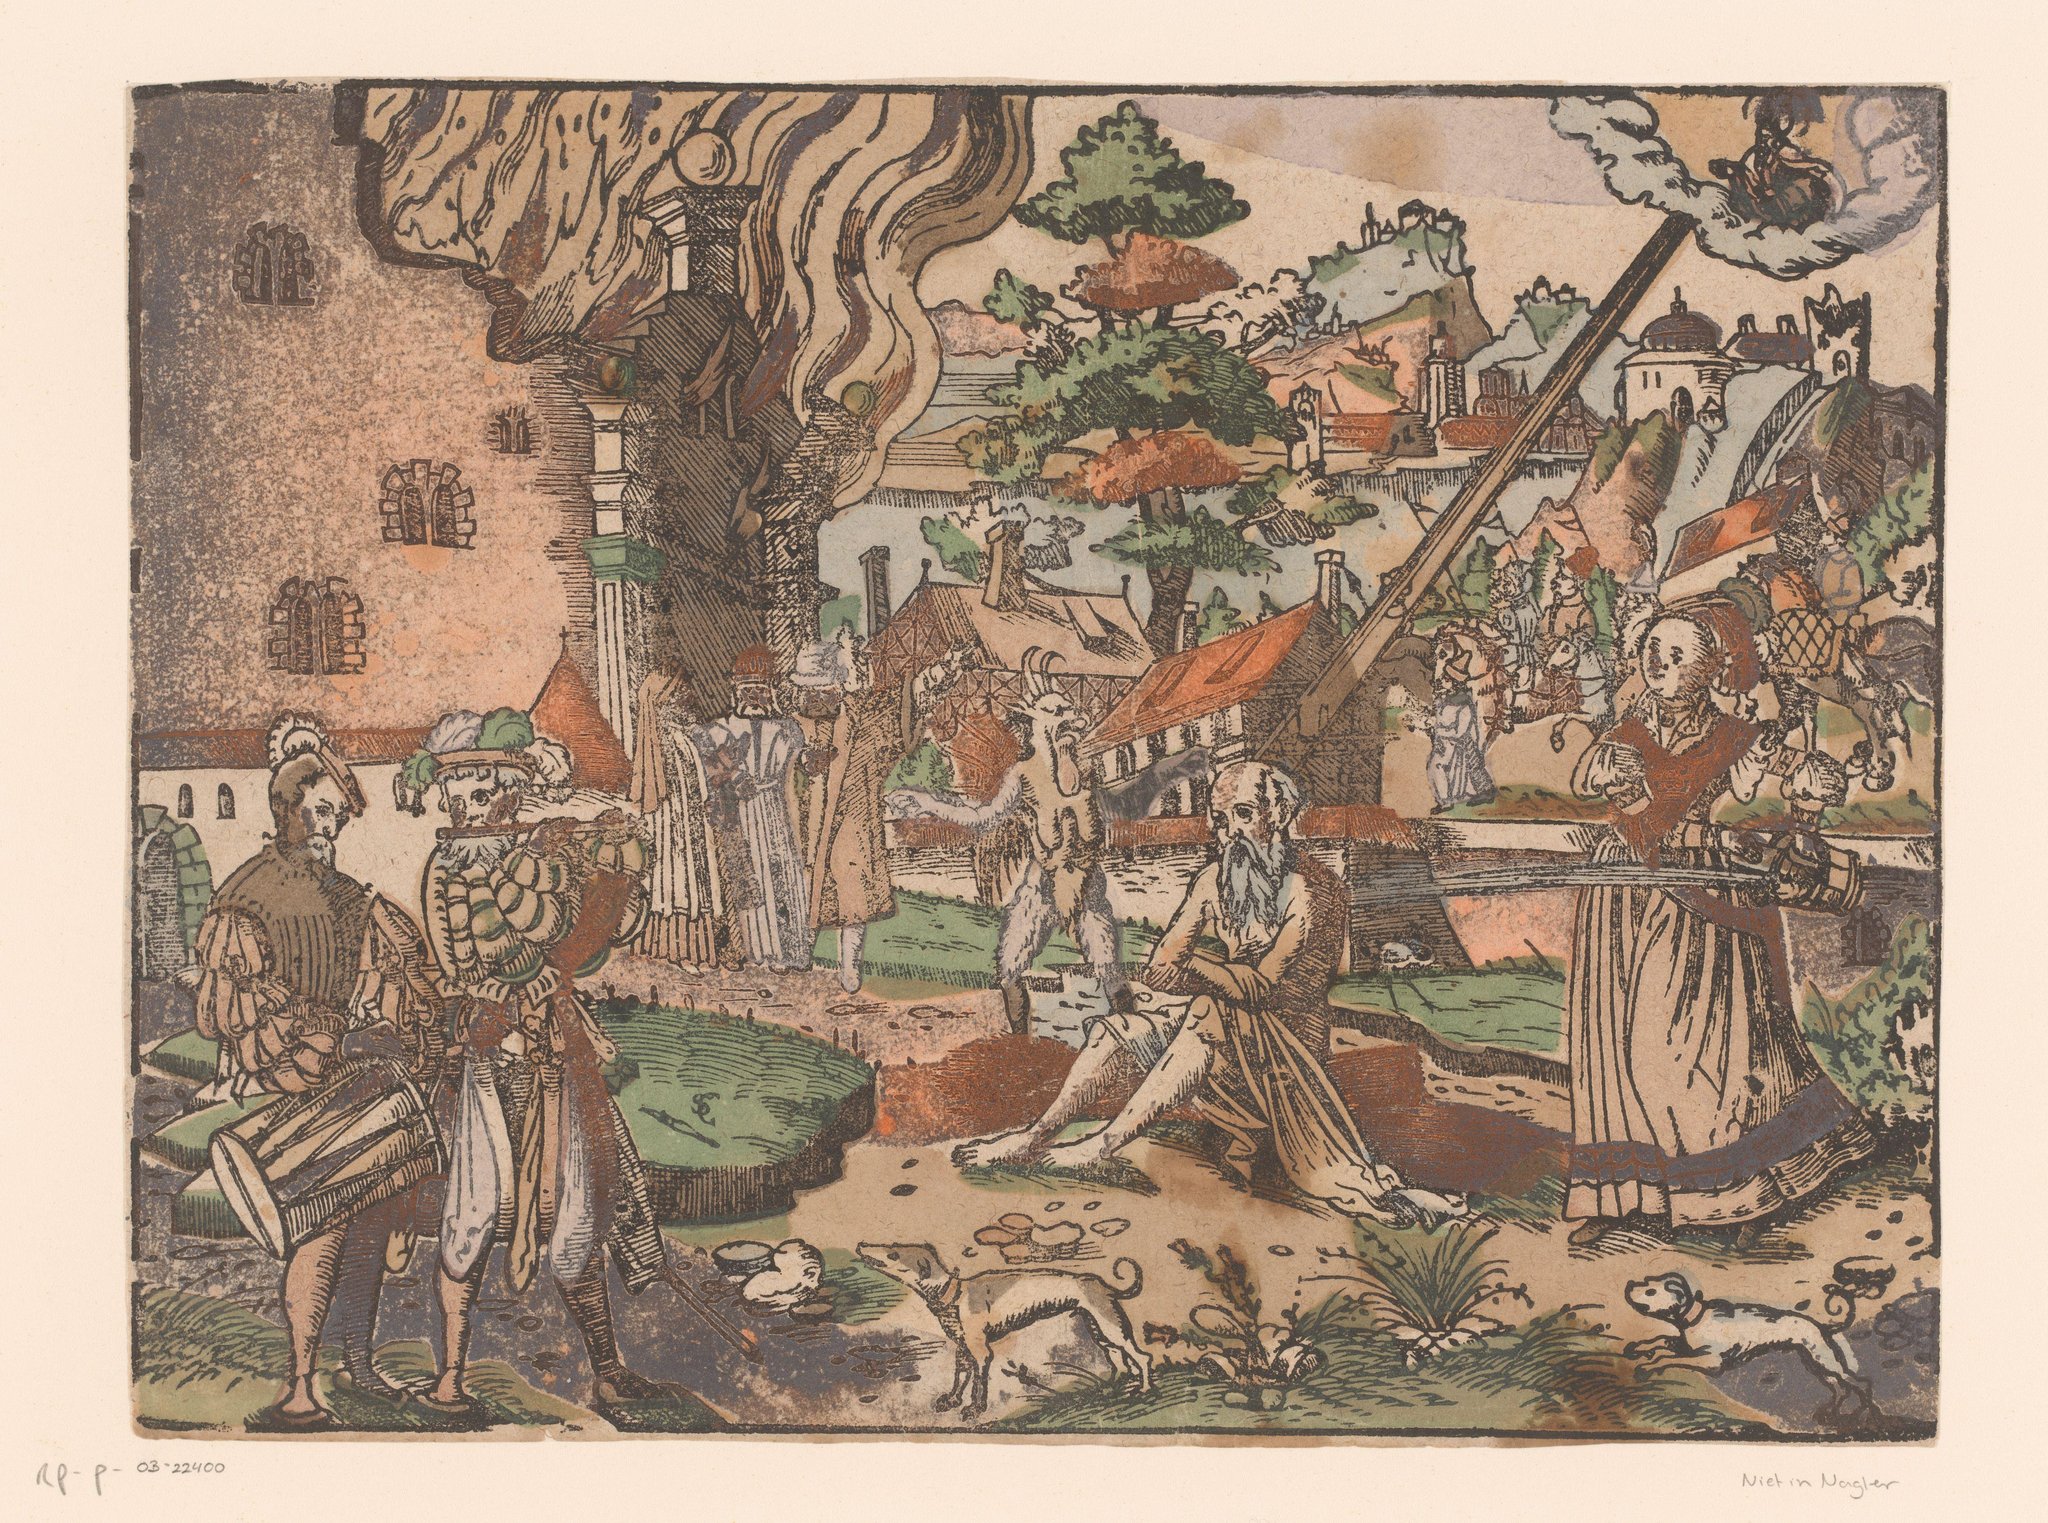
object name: print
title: Beproeving van Job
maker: Anonymous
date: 1500-1599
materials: paper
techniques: hand coloring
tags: job on the dunghill (job 2:7-13)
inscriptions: collector's mark: Lugt 240